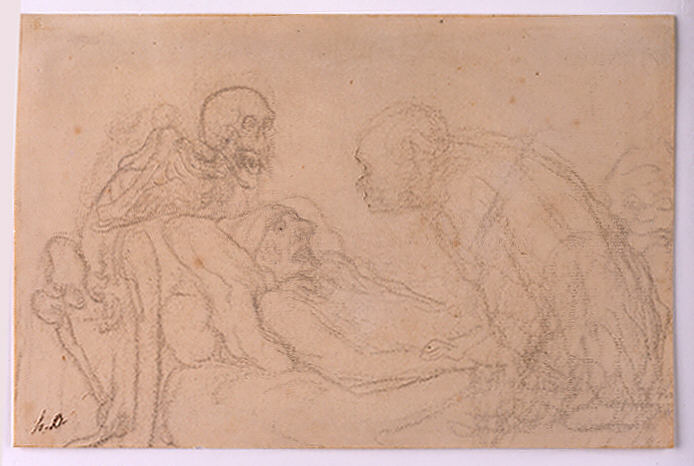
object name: drawing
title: Death and the Doctor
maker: honoré daumier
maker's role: artist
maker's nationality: french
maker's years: 1808-1879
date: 1860-1879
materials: chalk, charcoal, ink, paper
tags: skeletons,men,death